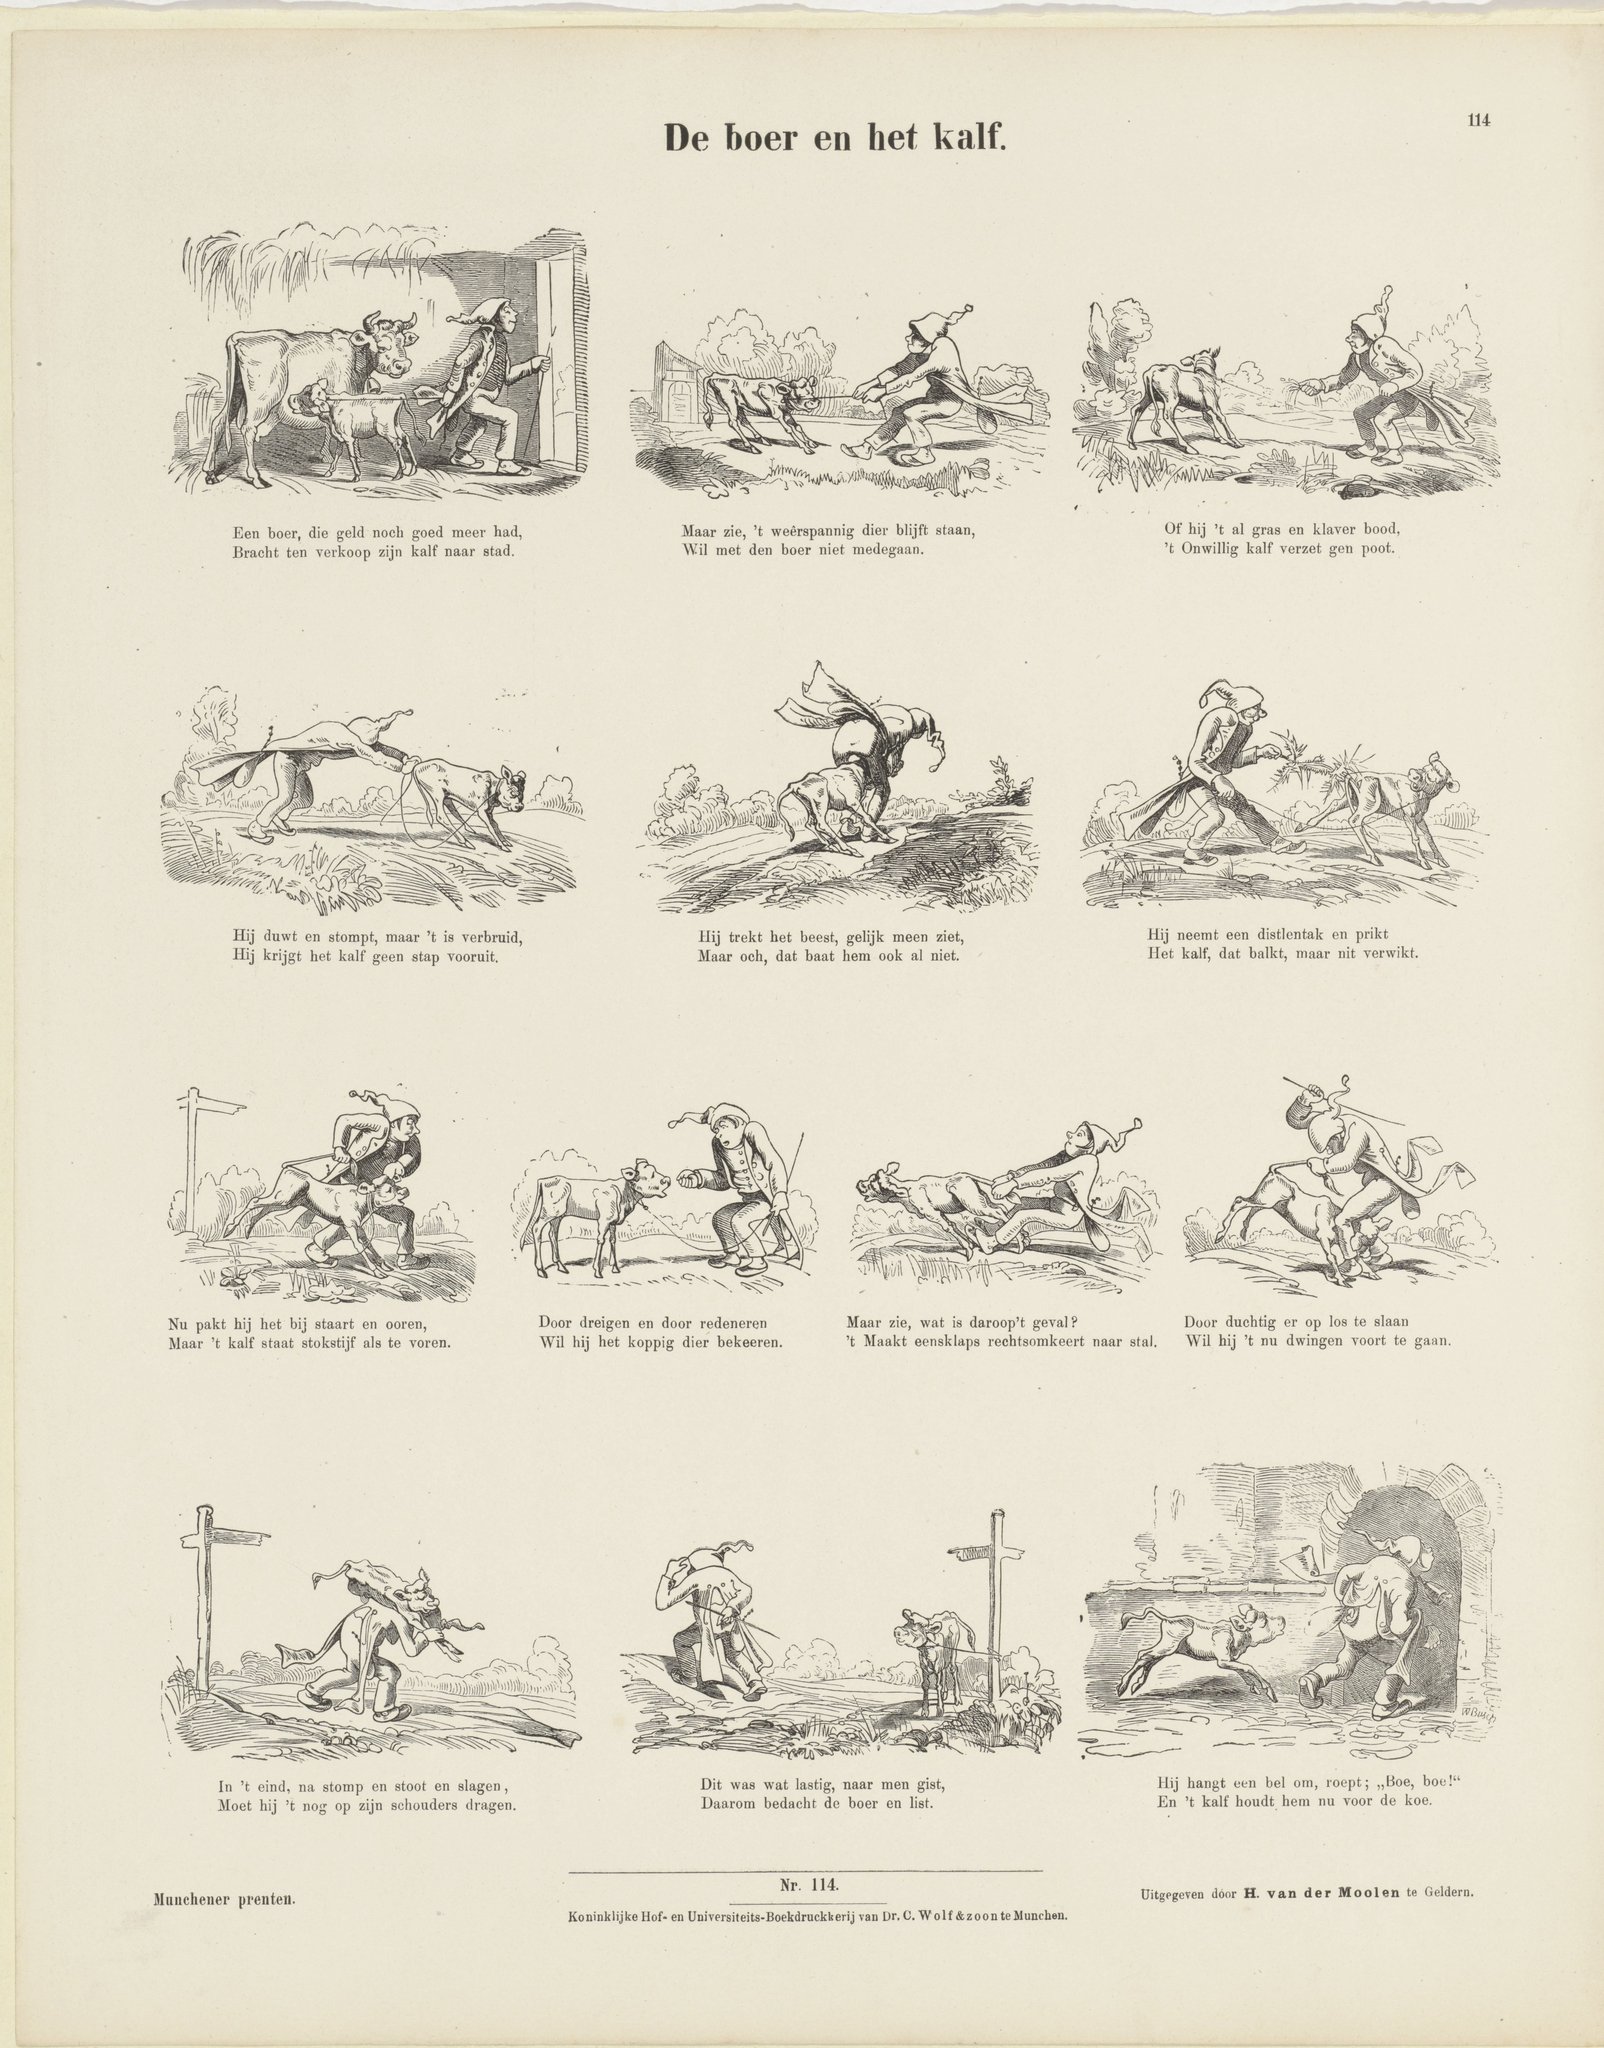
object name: print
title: De boer en het kalf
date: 1843-1920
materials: paper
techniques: letterpress printing, engraving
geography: munich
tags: farmers, calf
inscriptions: collector's mark: Lugt 2760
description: Blad met 13 voorstellingen over een boer en zijn kalf dat niet wil luisteren. Onder elke afbeelding een tweeregelig vers. Genummerd midden onder: Nro. 114. Genummerd rechtsboven: 114.